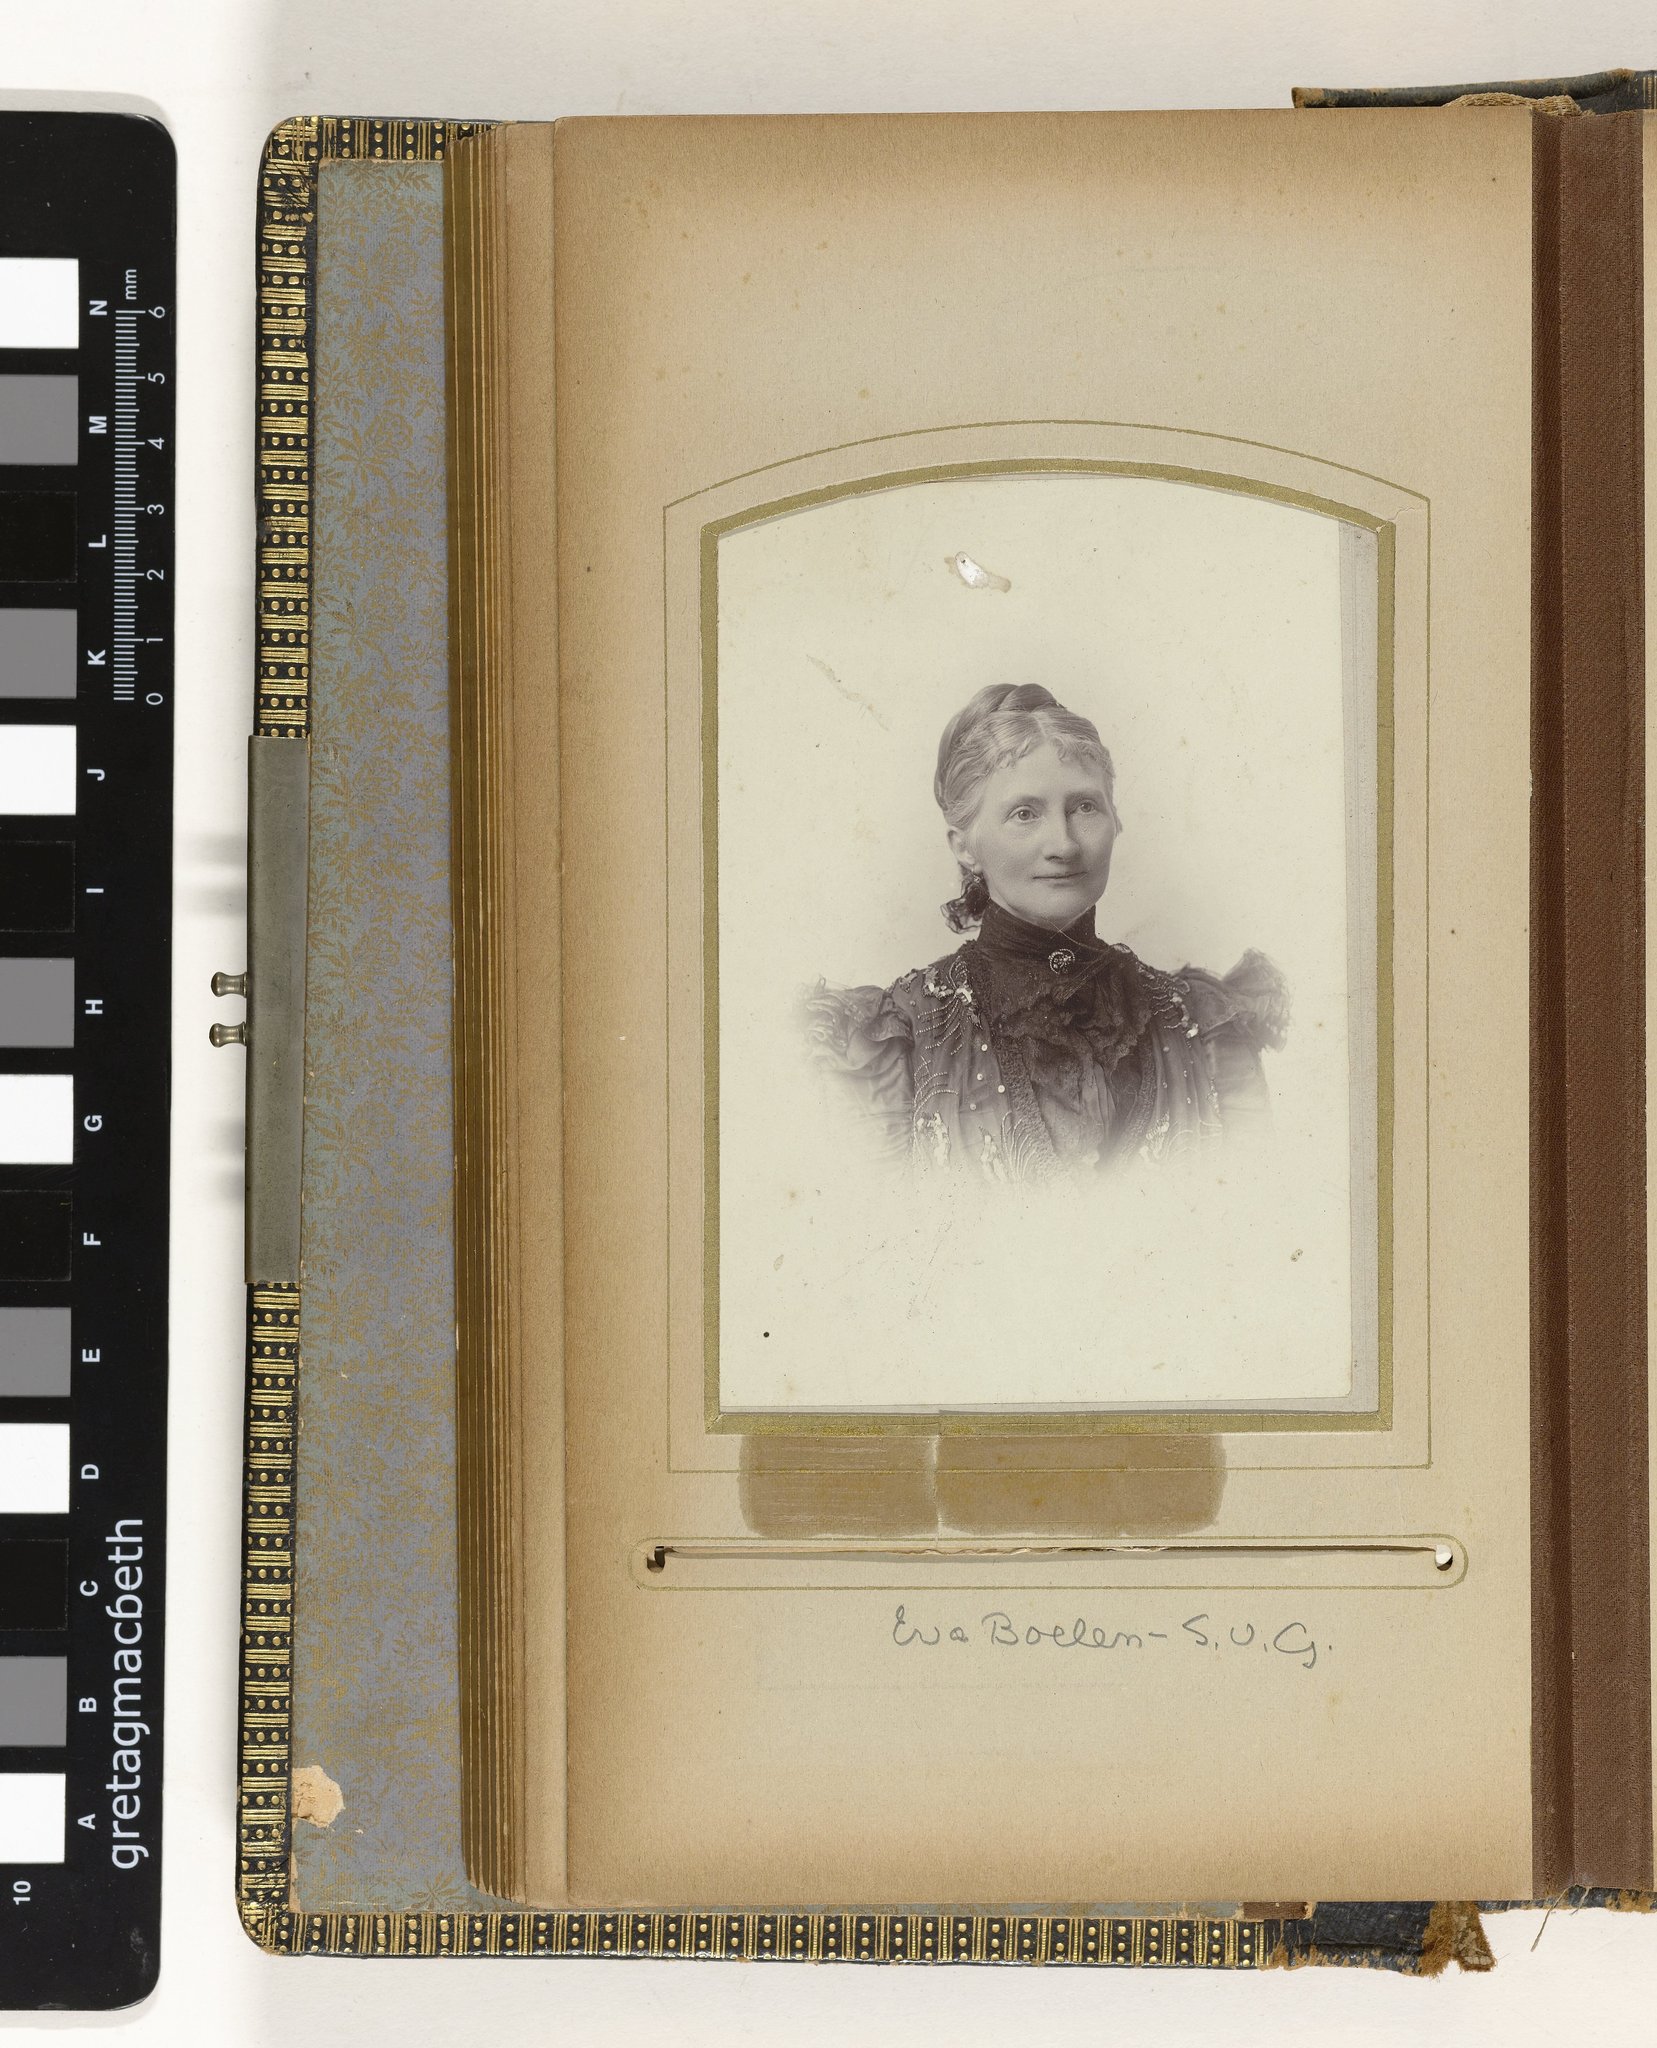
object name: photograph album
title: Fotoalbum van de familie Boelen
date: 1860-1910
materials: cardboard, leather, metal, paper, photographic support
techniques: albumen print, gelatin silver print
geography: netherlands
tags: studio requisites ~ photographer, historical persons, family life, netherlands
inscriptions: name: ‘Amsterdam City Magazijn Rotterdam’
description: Fotoalbum in zwarte leren band met metalen slot. Het voorplat is versierd met een metalen beslag in de vorm van lelies. Het achterplat heeft vier ijzeren knoppen en een geometrisch motief in reliëf. De schutbladen hebben een bloem- en plantmotief. Het album bevat 16 dikke kartonnen bladen met goud op snee. Elke pagina heeft één of twee met goudkleurige lijnen omkaderde passe-partouts. Daarin bevinden zich in totaal 42 cartes-de-visite, kabinetfoto's en foto's. Meerdere pasepartouts zijn leeg, maar hebben wel een bijschrift. Het betreft voornamelijk leden van de families Boelen, Waller, Schmidt van Gelder, Coster en Kruimel. Het fotoalbum is afkomstig uit de nalatenschap van Eva Pennink.